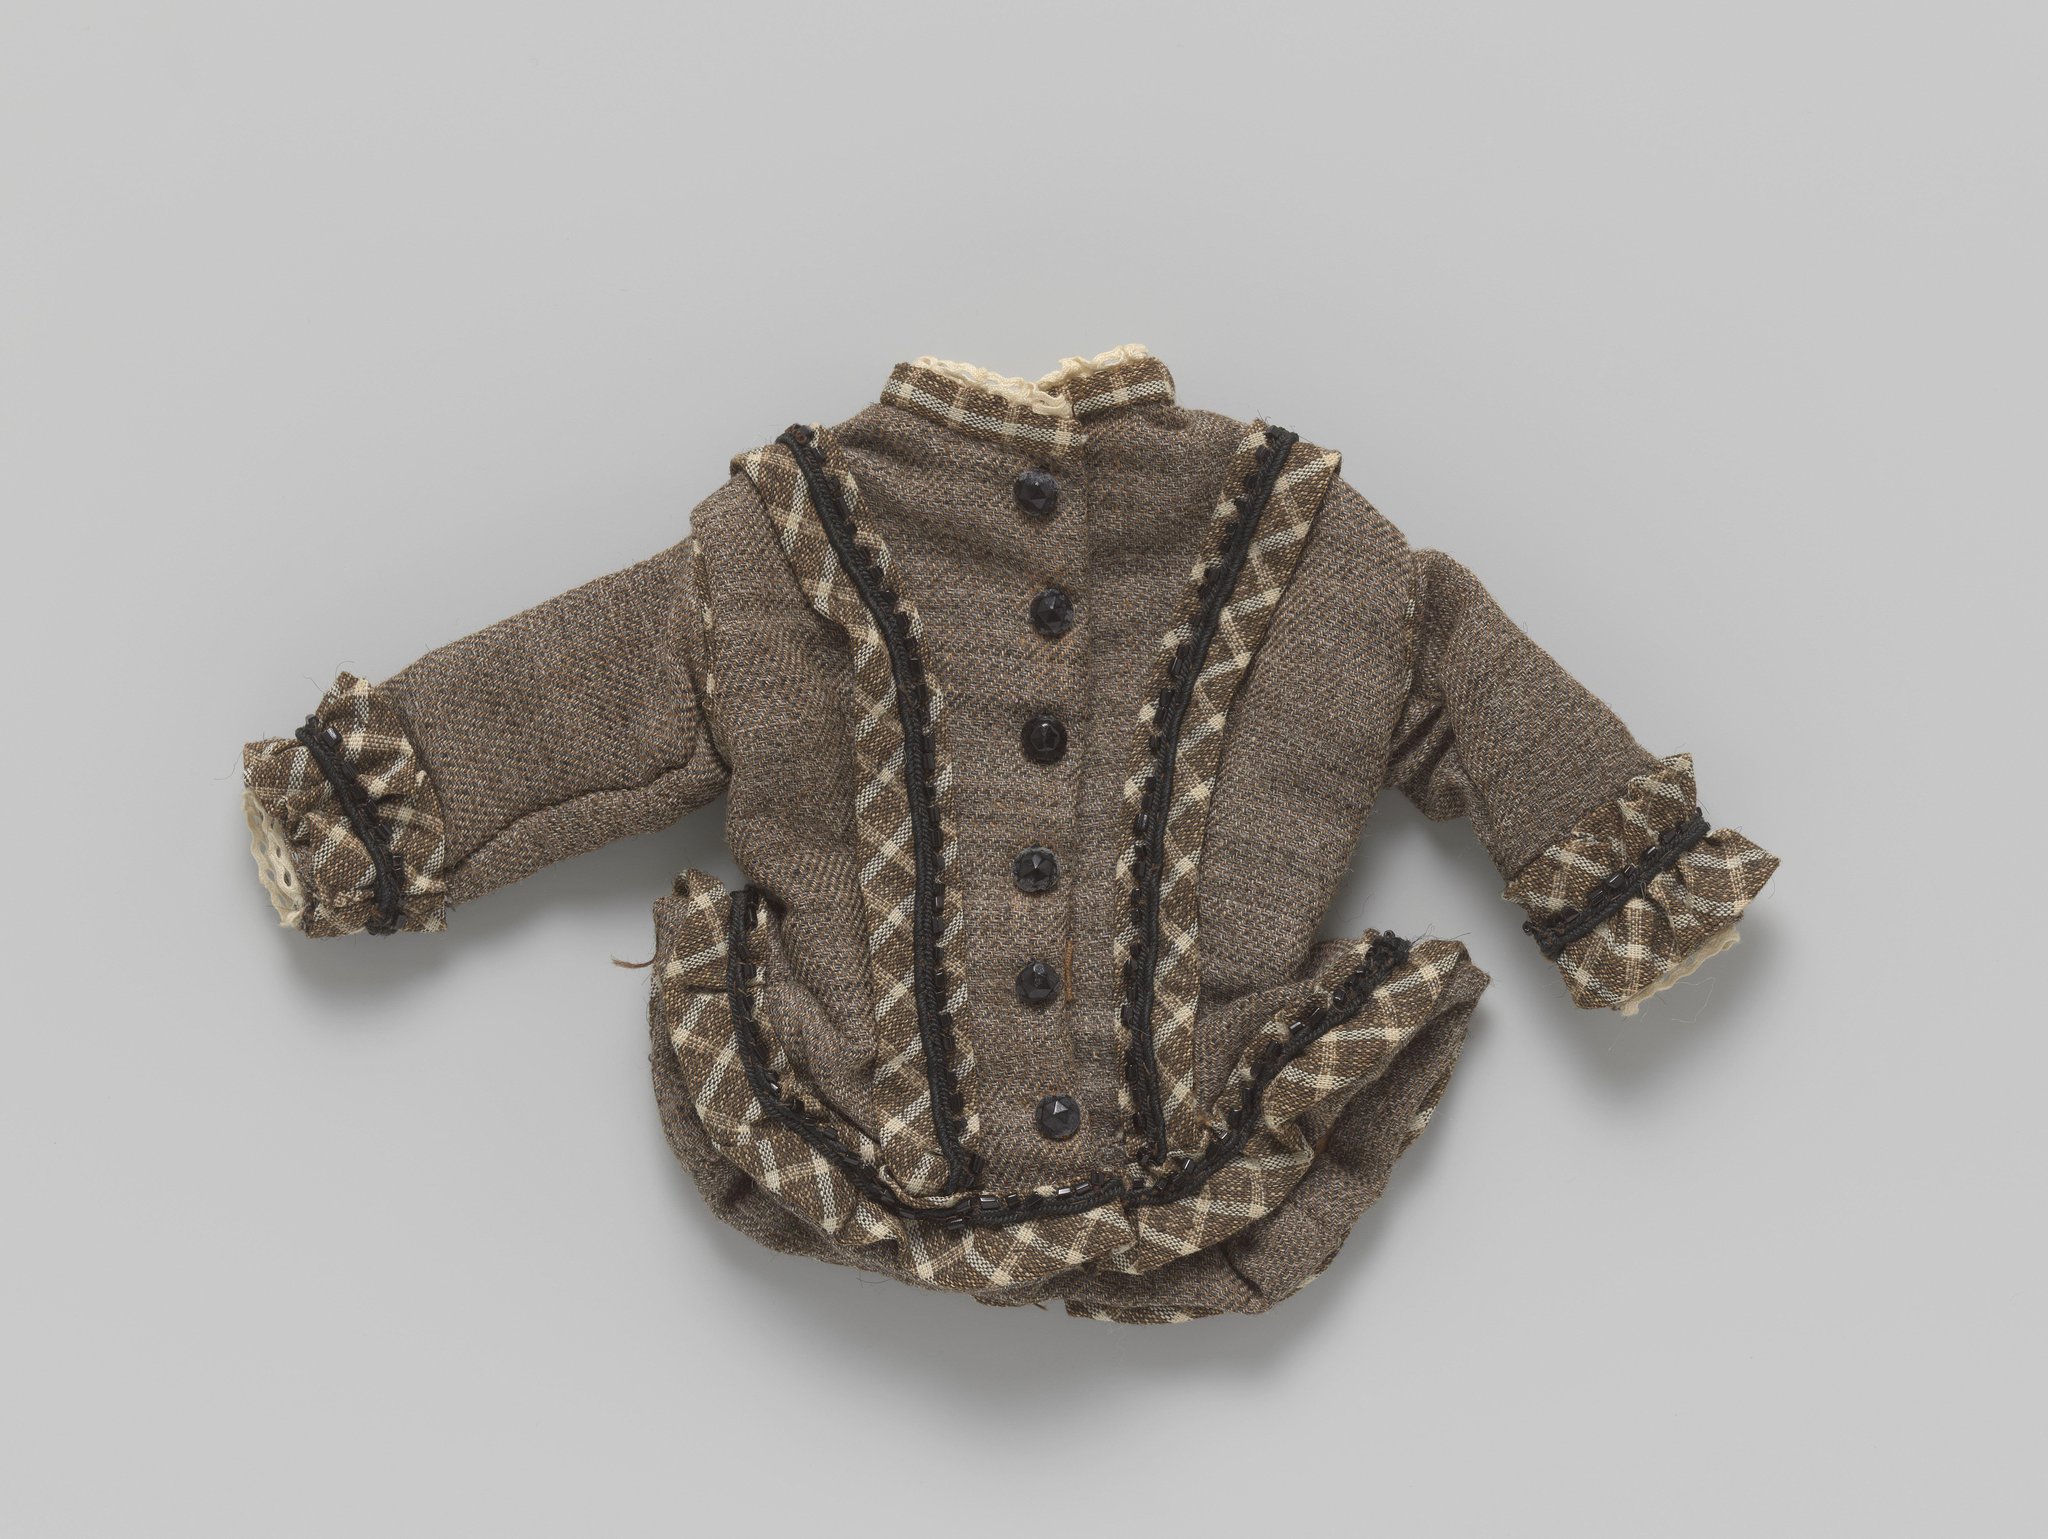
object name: doll's clothing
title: Lijfje van bruine wol met geruite biesjes en gitten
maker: Anonymous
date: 1850-1920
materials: jet, wool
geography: europe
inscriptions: number: ‘RBK15445’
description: Het lijfje met lange mouwen sluit aan de voorzijde met zes knoopjes van facet geslepen gitten.